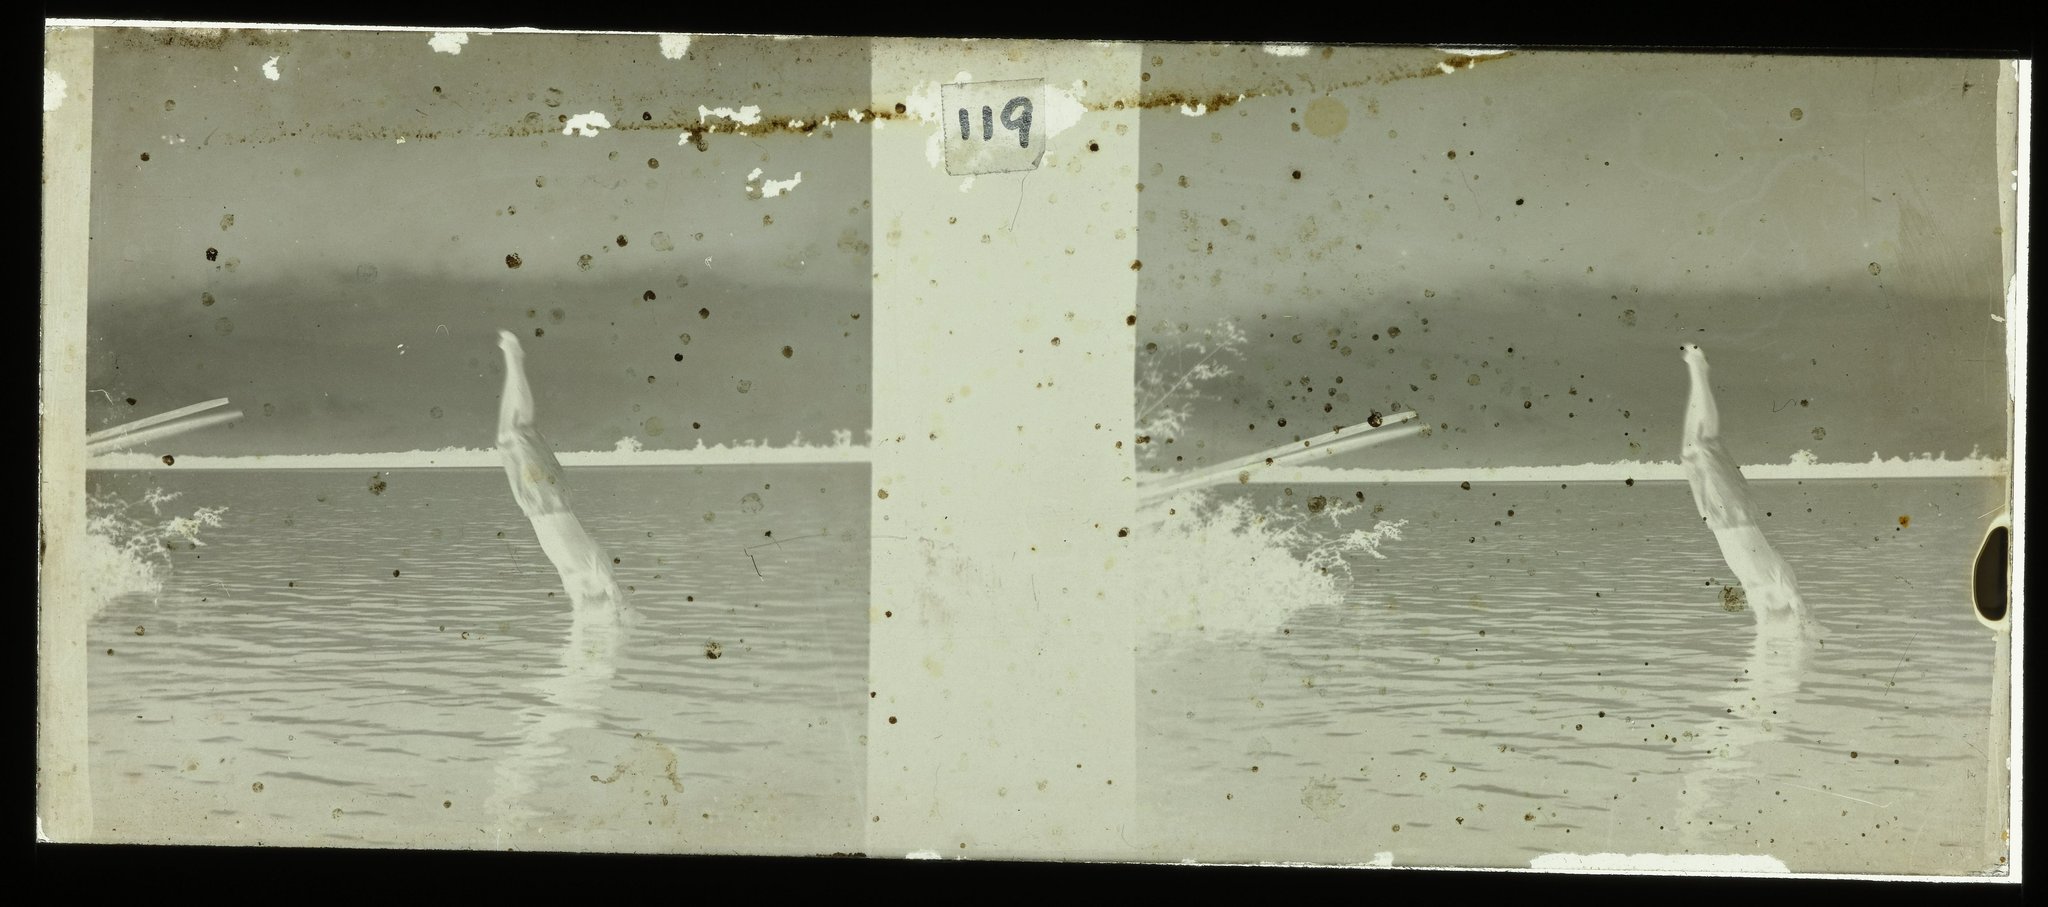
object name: stereograph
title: Duiker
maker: theodoor brouwers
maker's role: amateurfotograaf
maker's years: 1874-1932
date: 1913-1930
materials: glass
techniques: photography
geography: suriname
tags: amsterdam, theodoor brouwers, suriname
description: In de periode 1911-1932 woonde op plantage Accaribo in Suriname de familie Brouwers van wie de foto's afkomstig zijn. Rond 1910 vond Theodoor Brouwers werk op plantage Accaribo. In 1929 werd hij eigenaar van de plantage. Op Accaribo werden in zijn tijd bananen geproduceerd en wat koffie.